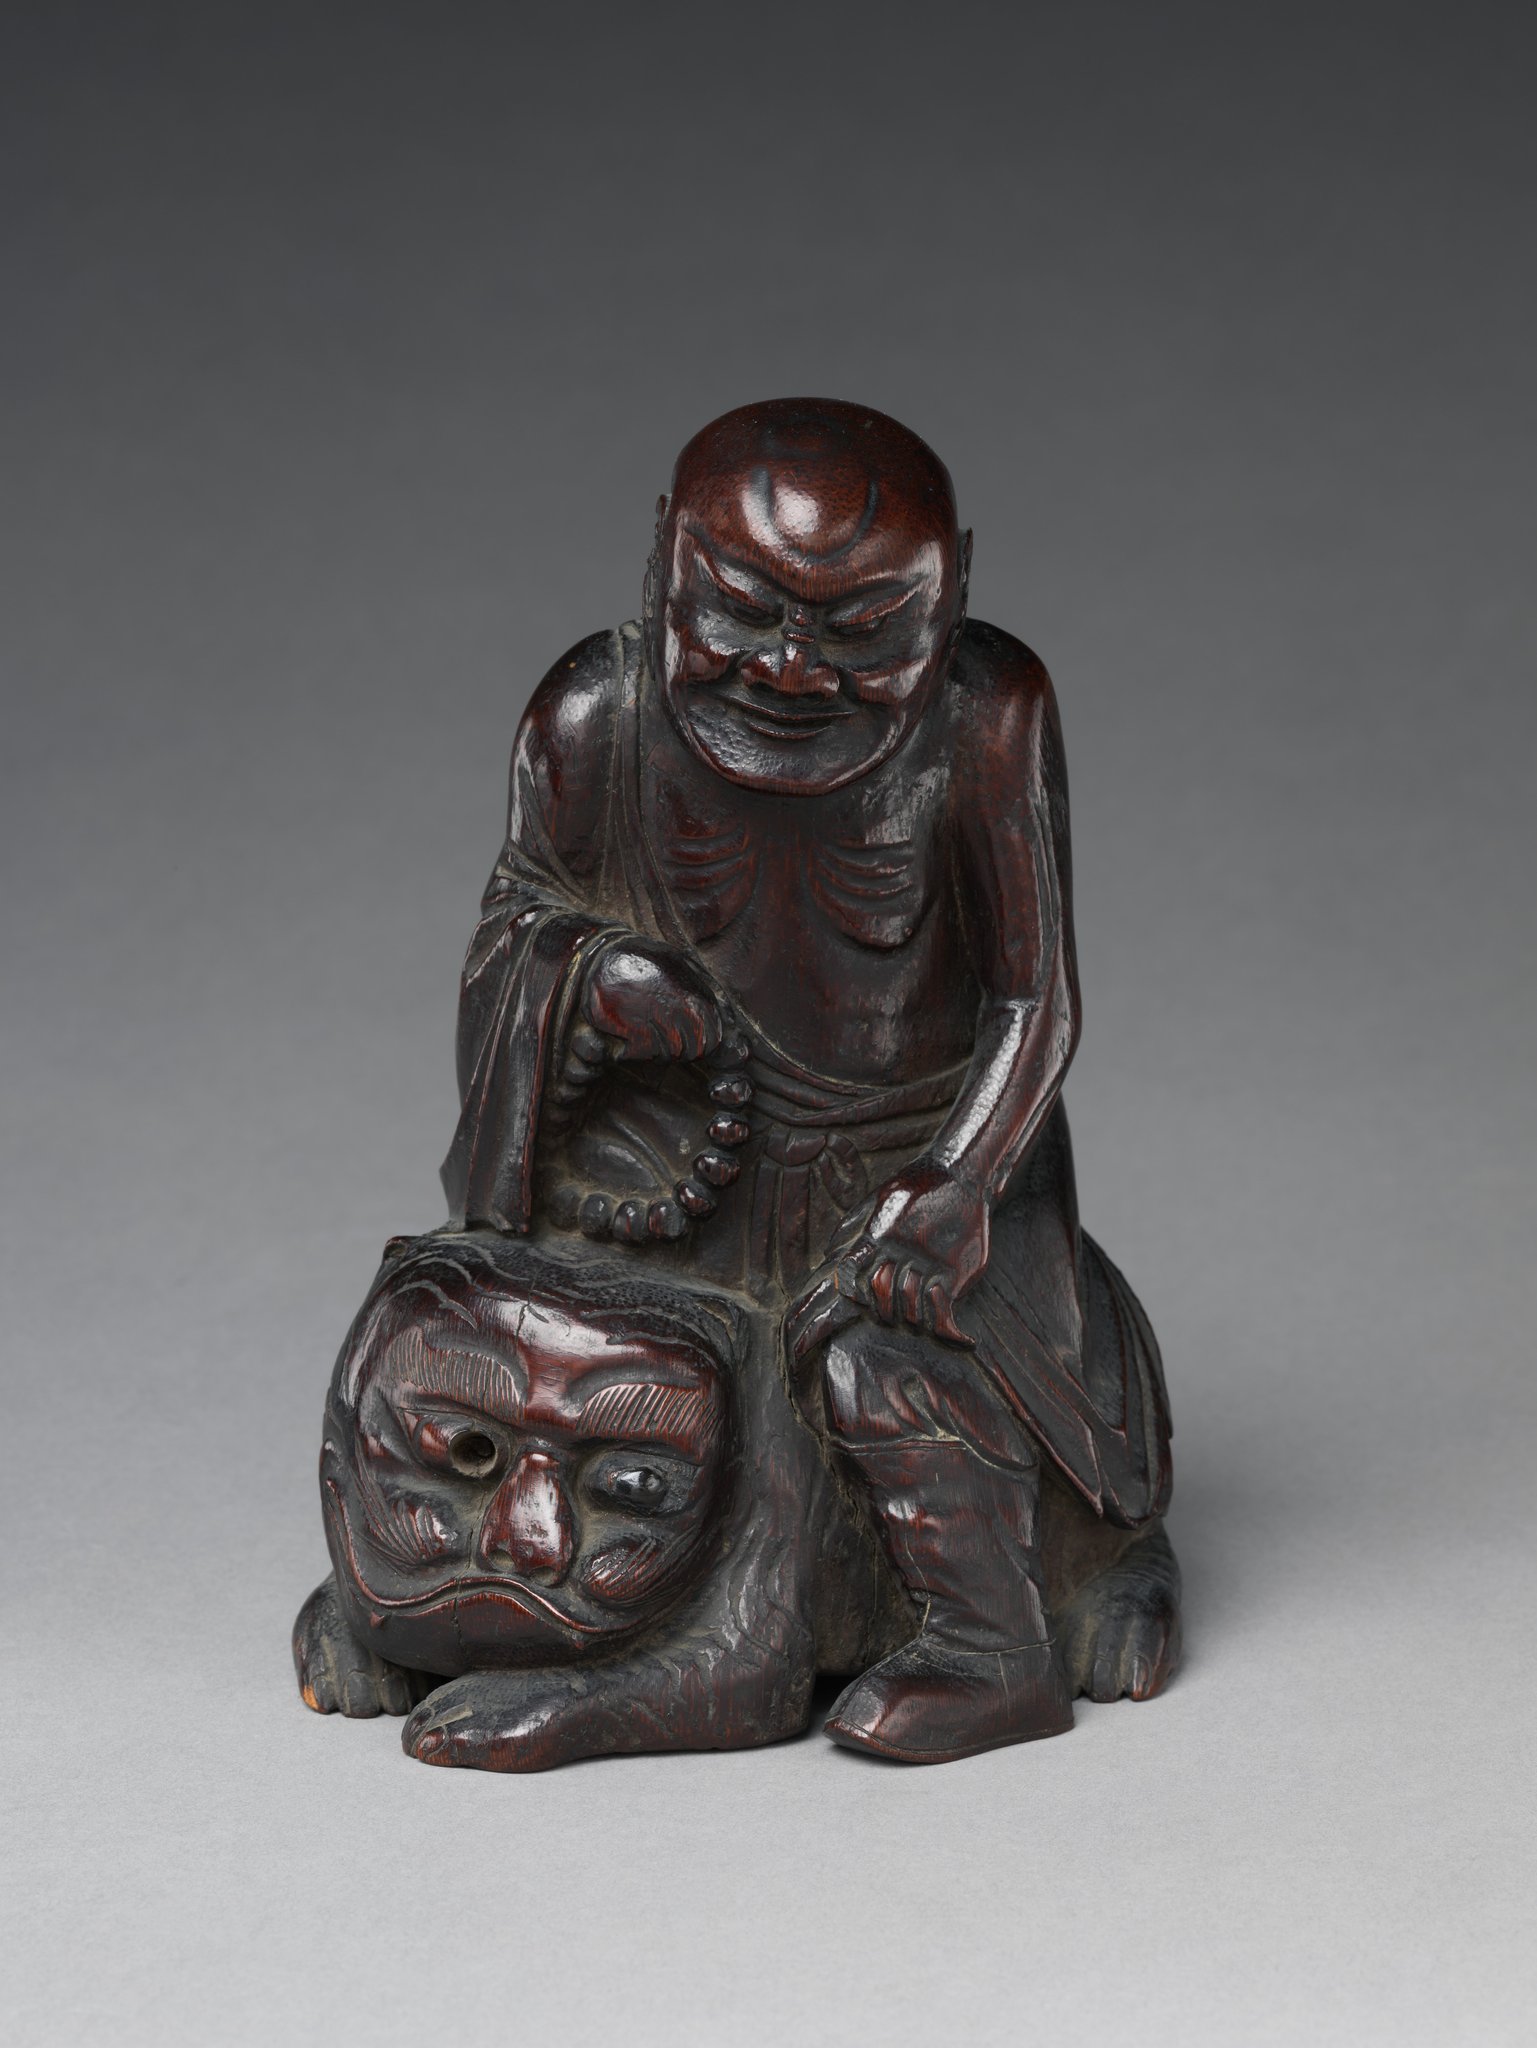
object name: figure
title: Arhat with a tiger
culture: chinese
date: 1701-1800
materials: bamboo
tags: men